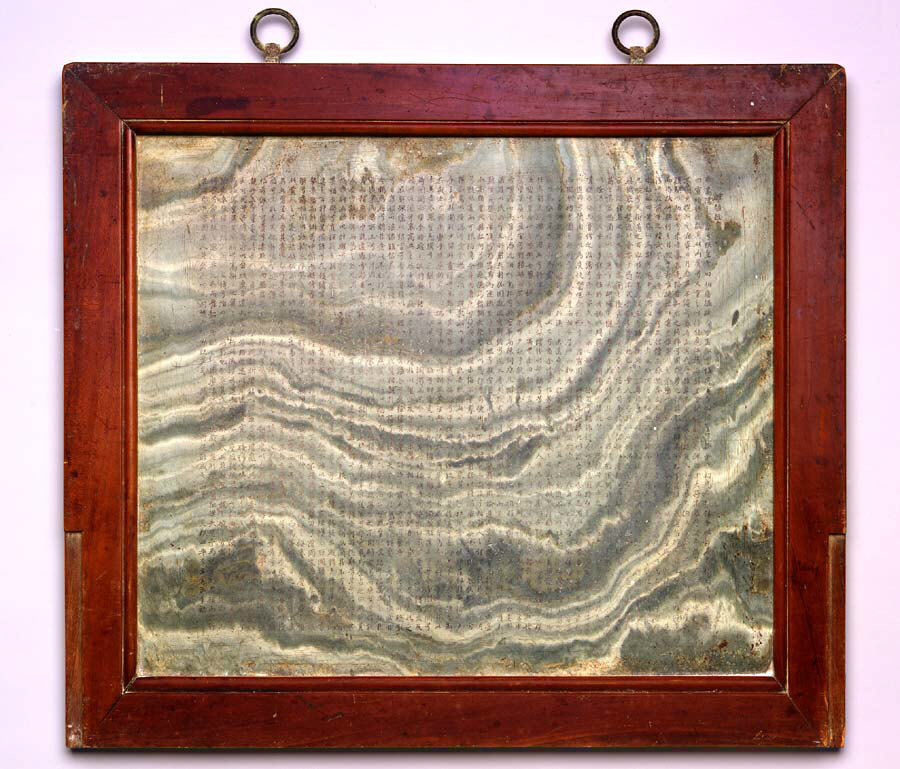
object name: table screen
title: Table Screen Inscribed with the Poem "Lisao," now converted to a wall panel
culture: chinese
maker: li mi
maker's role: artist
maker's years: 1600-1699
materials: marble, wood